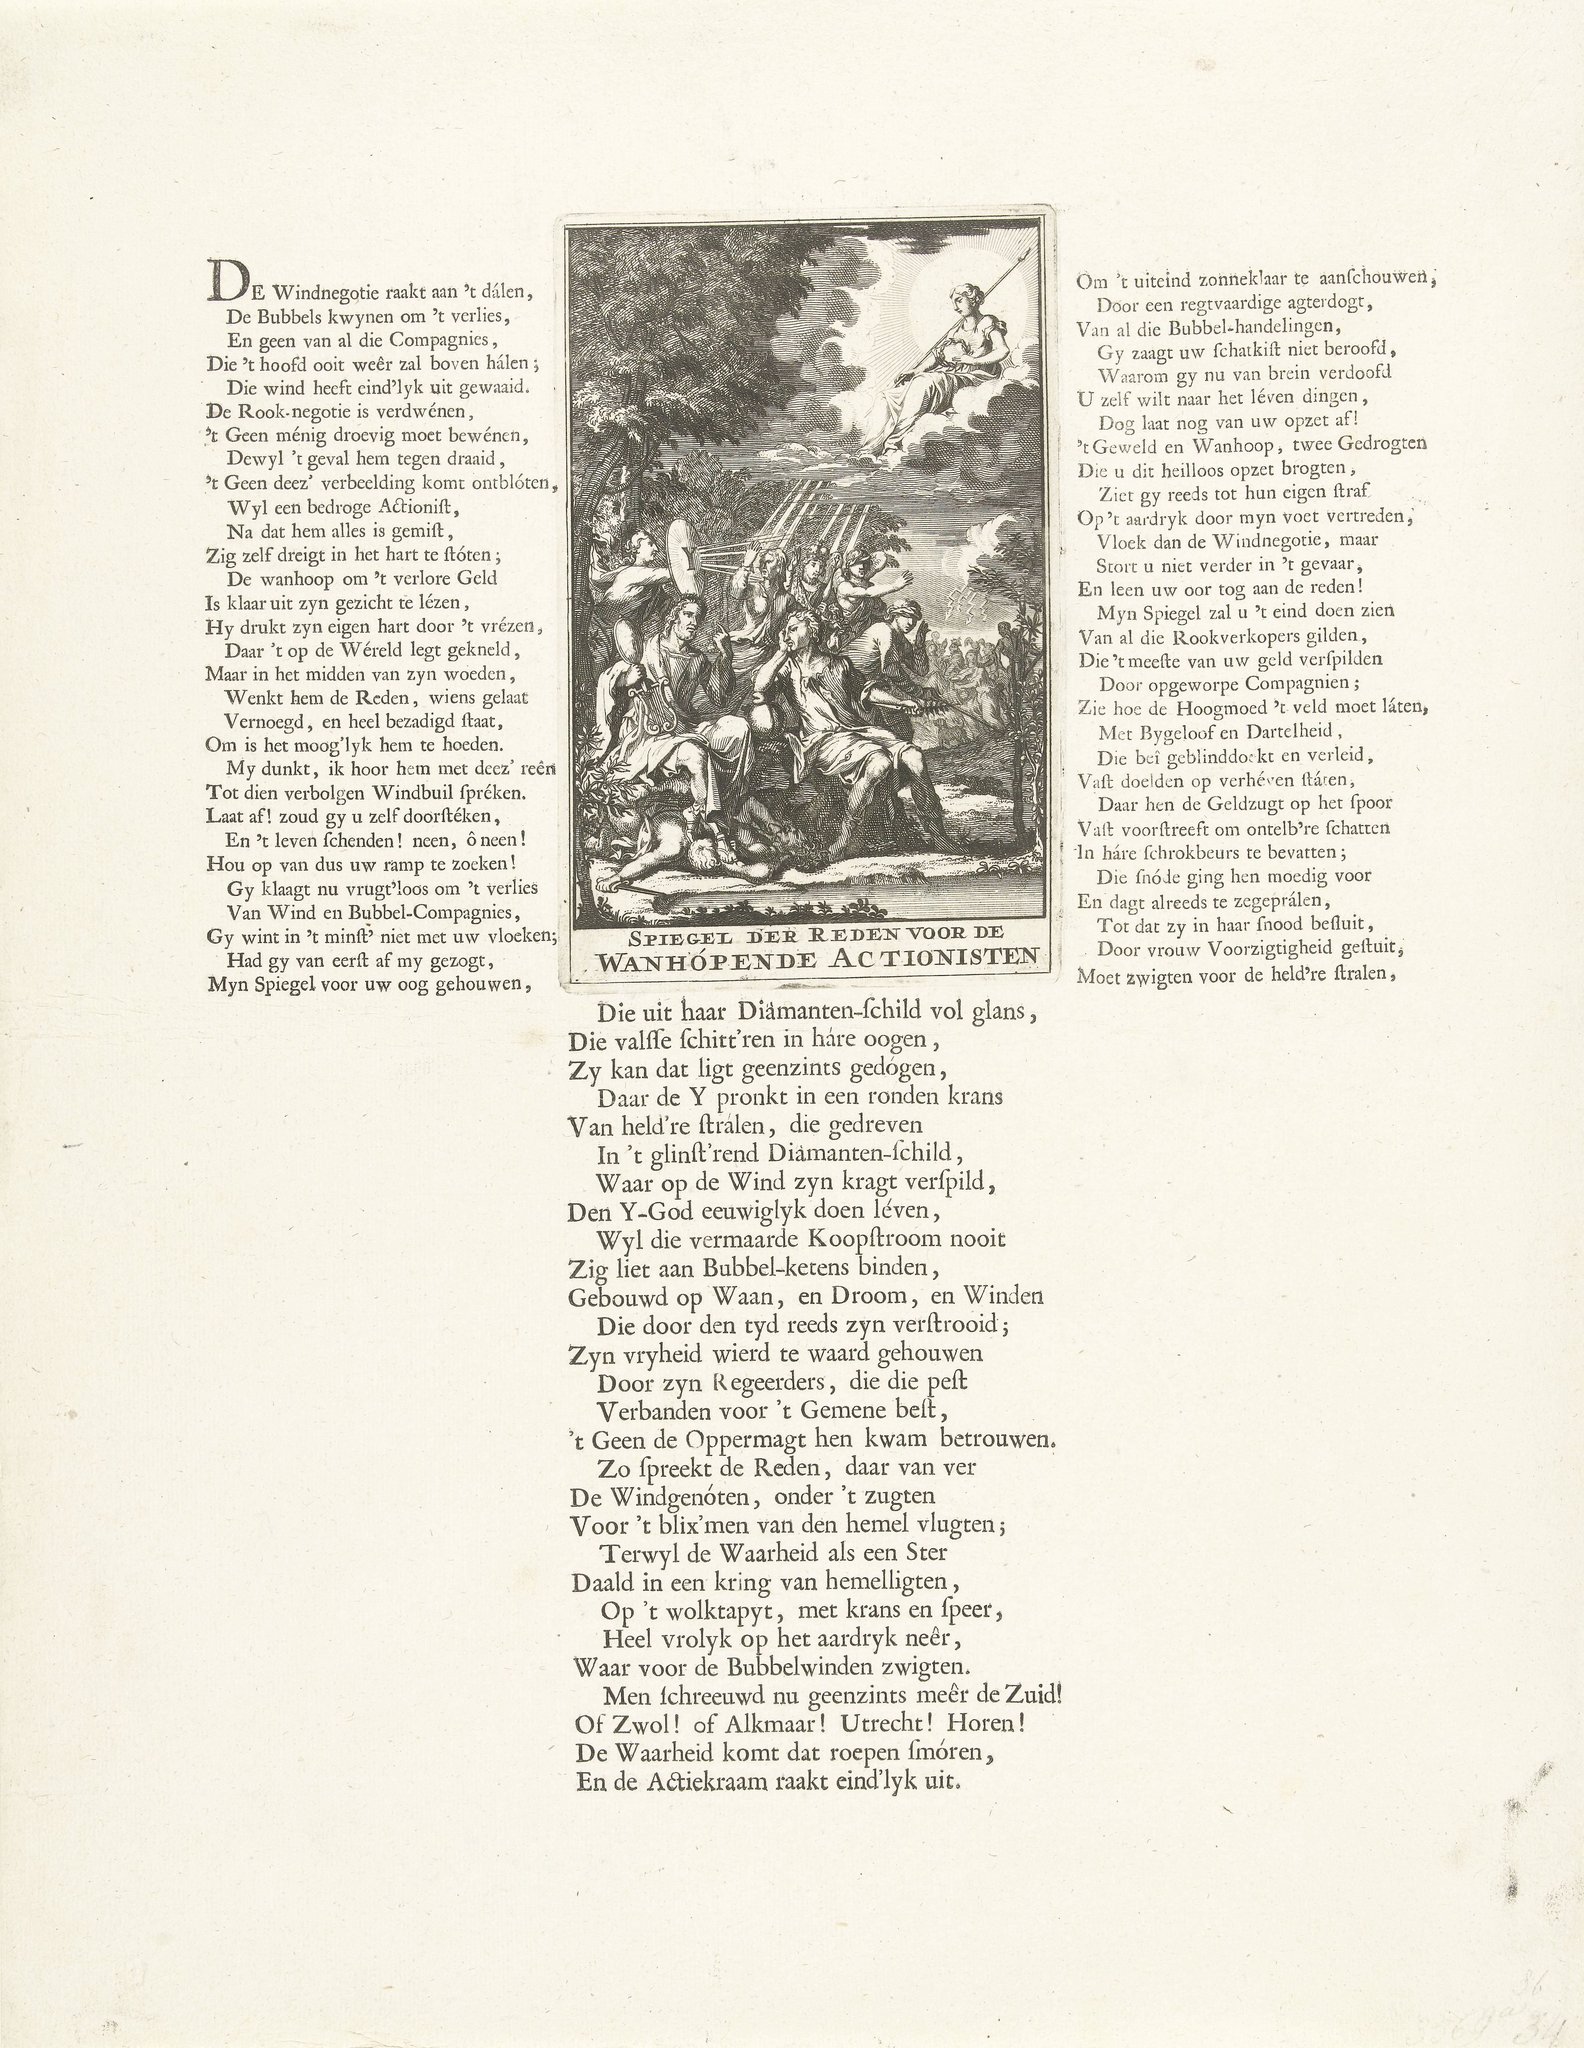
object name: cartoon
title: Spiegel der Reden voor de wanhopende Actionist, 1720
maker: jacobus schijnvoet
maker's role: draughtsman, print maker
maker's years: 1685-1743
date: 1720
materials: paper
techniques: engraving, etching, letterpress printing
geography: amsterdam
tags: financial panic, rationality, reasoning; 'ratiocinatione o discorso' (ripa) (+ abstract concept represented by male figure)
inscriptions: collector's mark: Lugt 2228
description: Spiegel der Reden voor de wanhopende Actionist. Een windhandelaar die op het punt staat zich met een dolk in de borst te steken wordt door de personificatie van de Reden een spiegel voorgehouden. Op de achtergrond houdt de Voorzichtigheid met een schild gemerkt Y (= het IJ te Amsterdam) de windhandel tegen. Op het blad om de plaat staan drie delen tekst. Prent 34 in de serie Het Groote Tafereel der Dwaasheid met spotprenten op de Windhandel of Actiehandel van 1720.